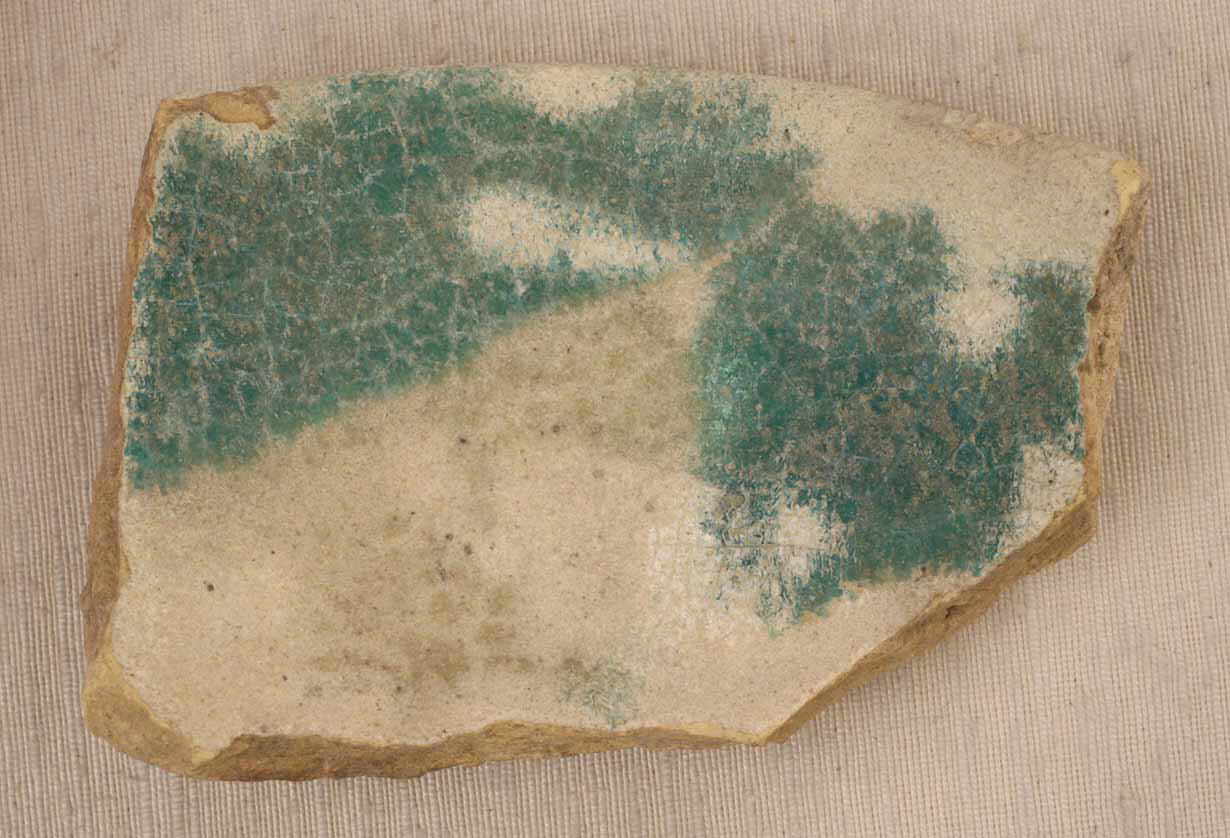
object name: fragment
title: Ceramic Fragment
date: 701-900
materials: earthenware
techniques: glazing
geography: iraq